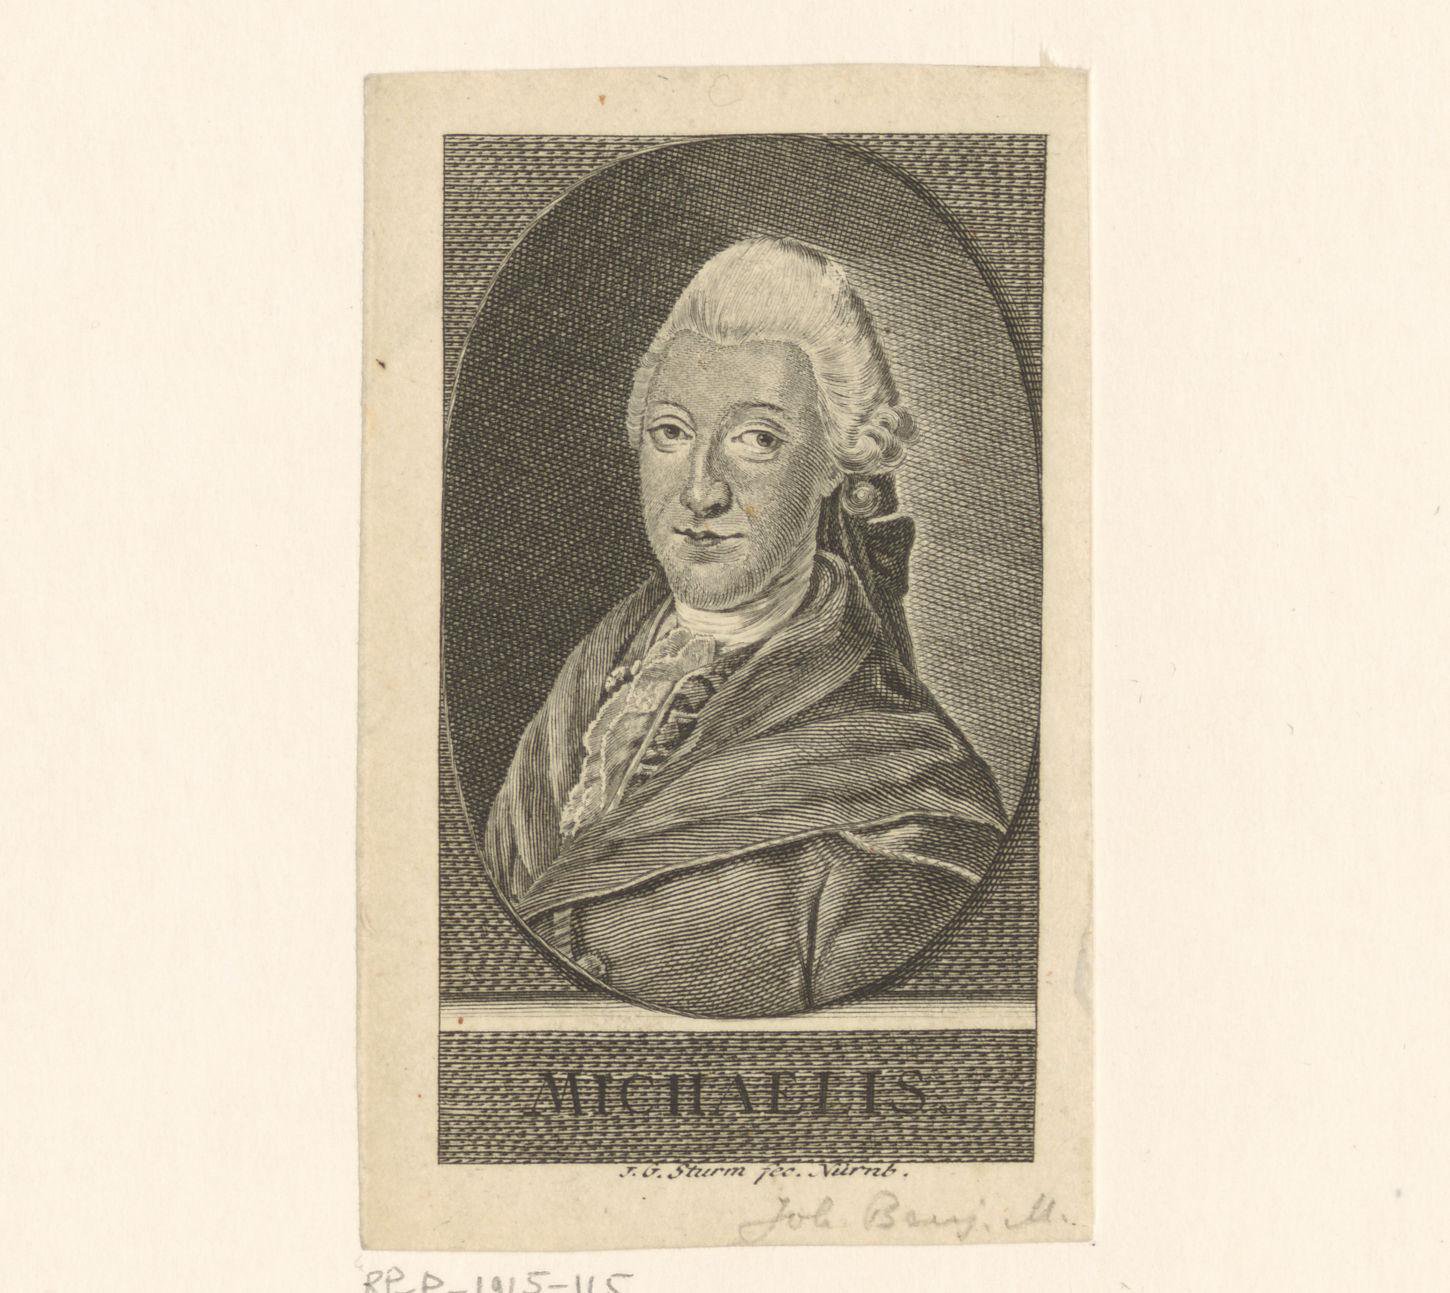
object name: print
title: Portret van Johann David Michaelis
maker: johann georg sturm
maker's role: print maker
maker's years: 1742-1793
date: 1752-1793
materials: paper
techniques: engraving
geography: nuremberg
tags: historical persons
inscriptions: collector's mark: Lugt 2228